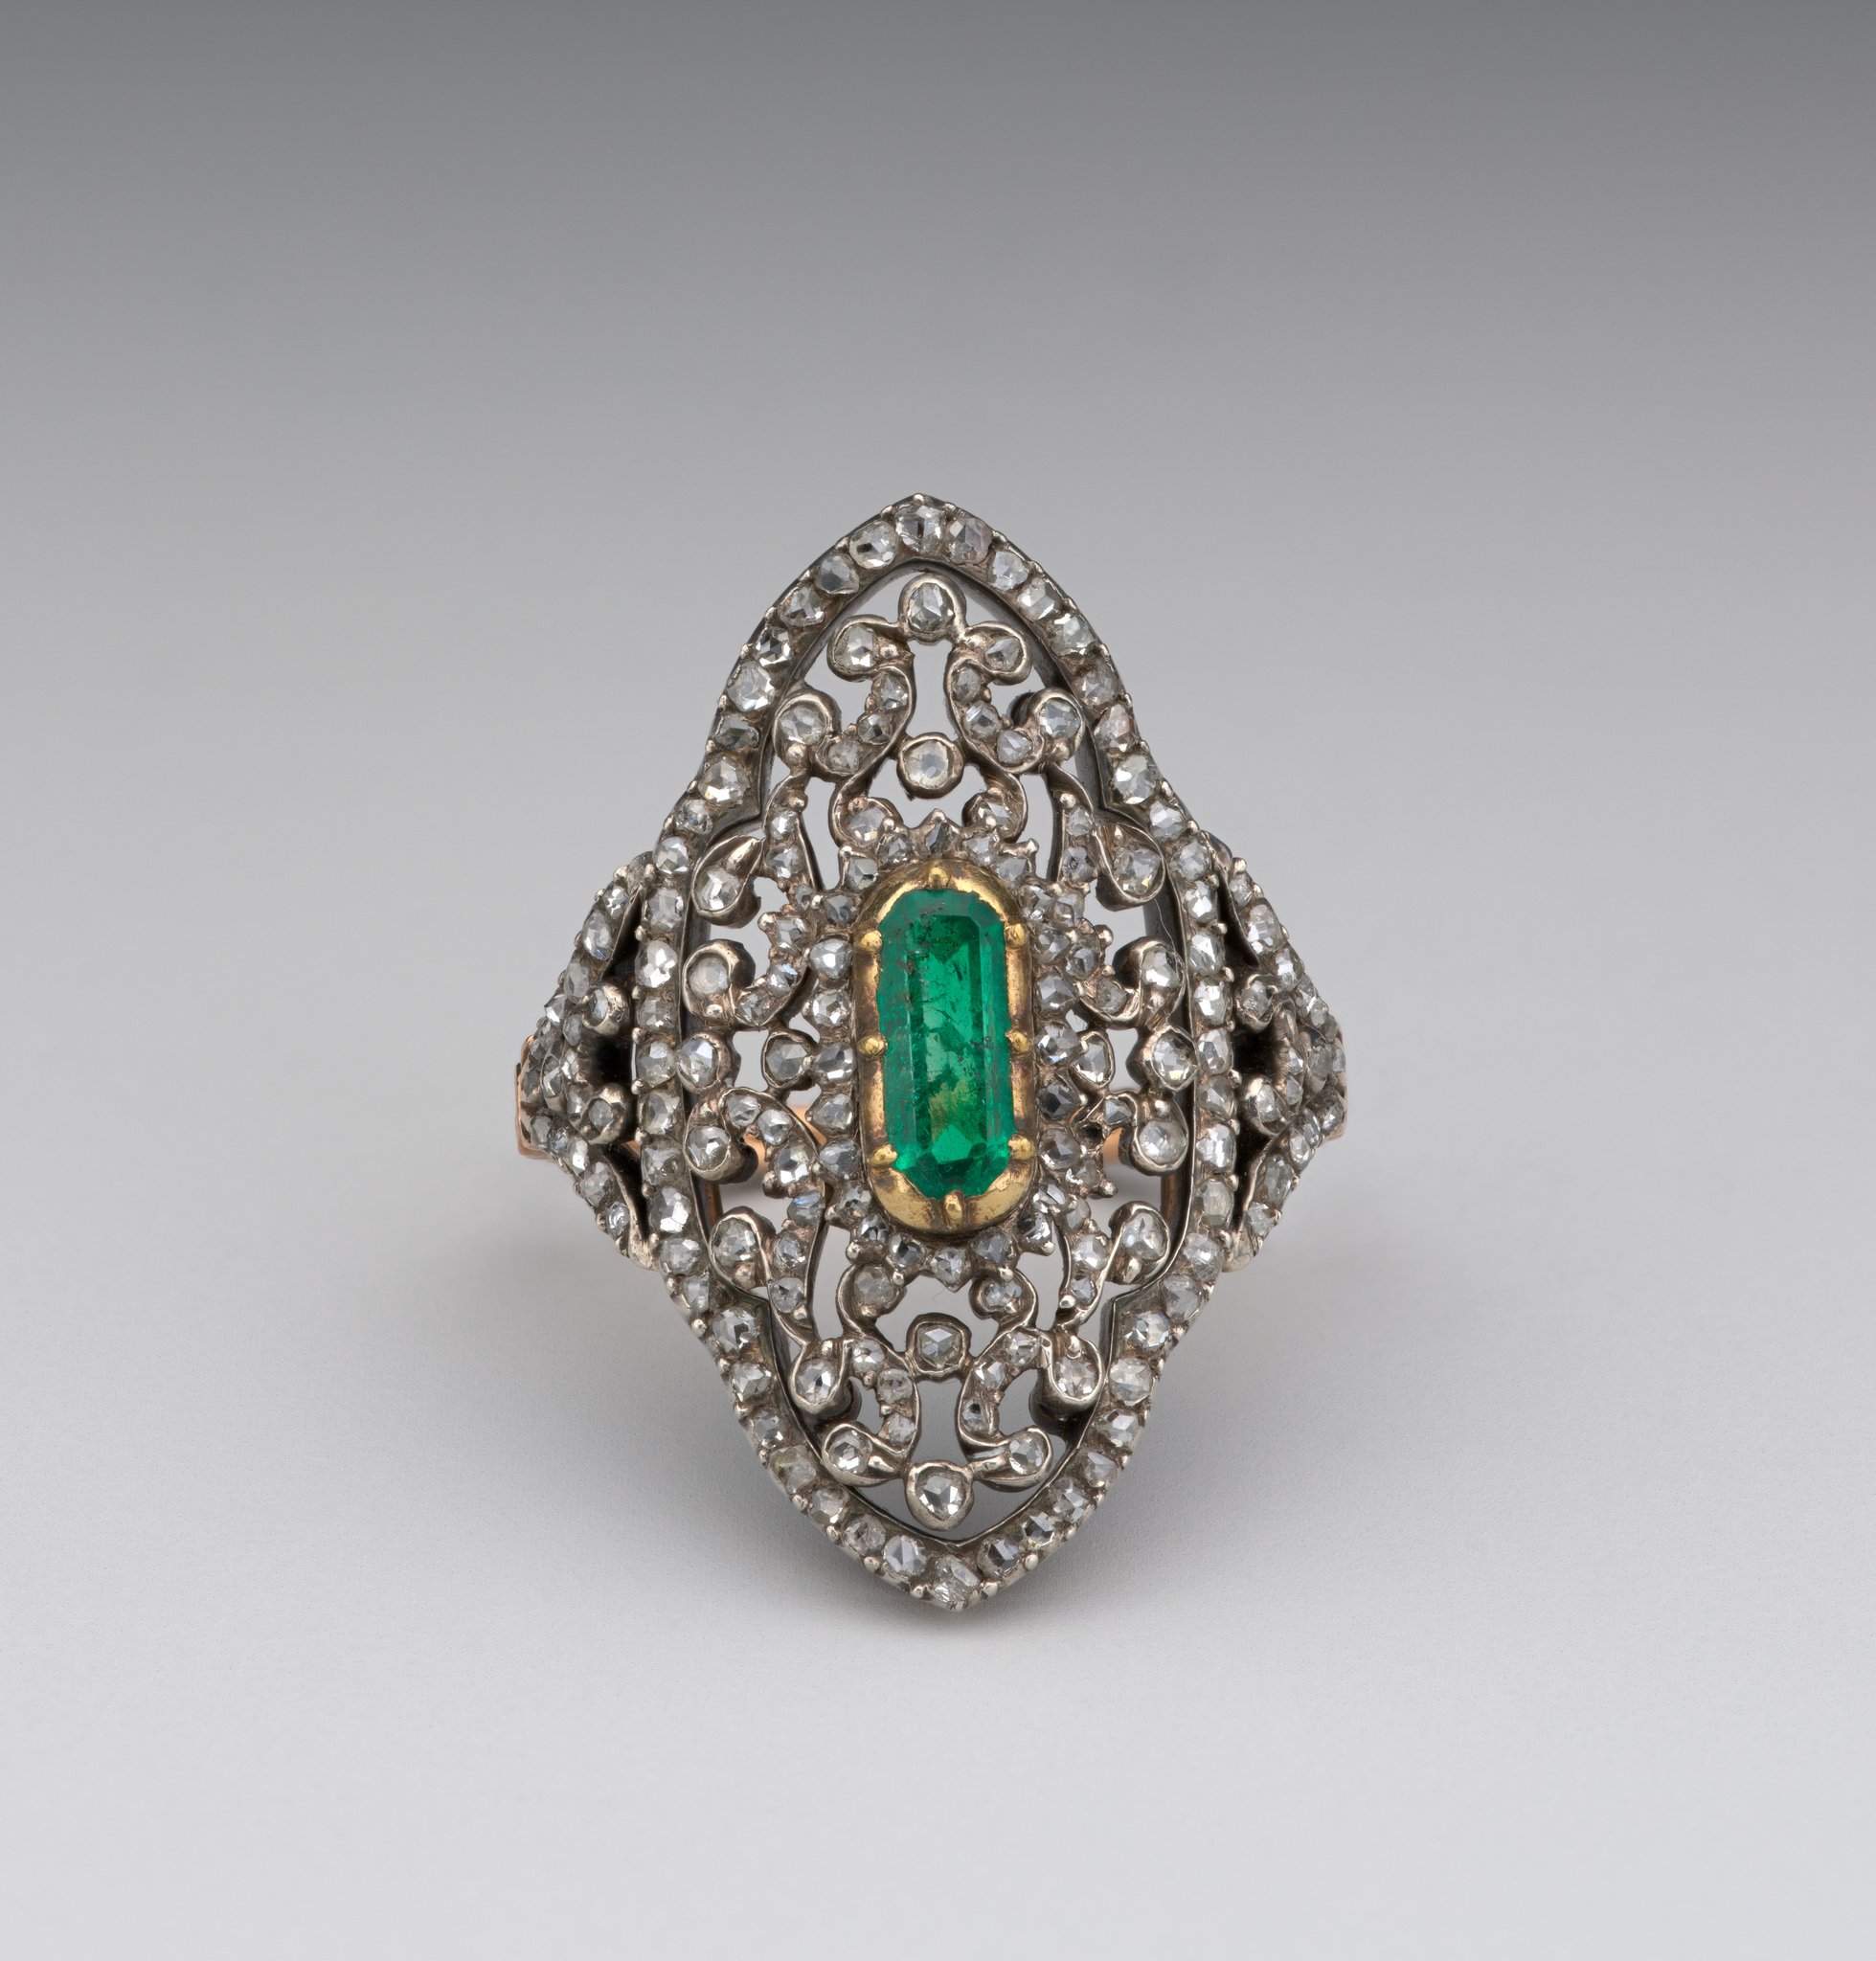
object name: ring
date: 1838-1847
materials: diamond, gemstone, gold, silver